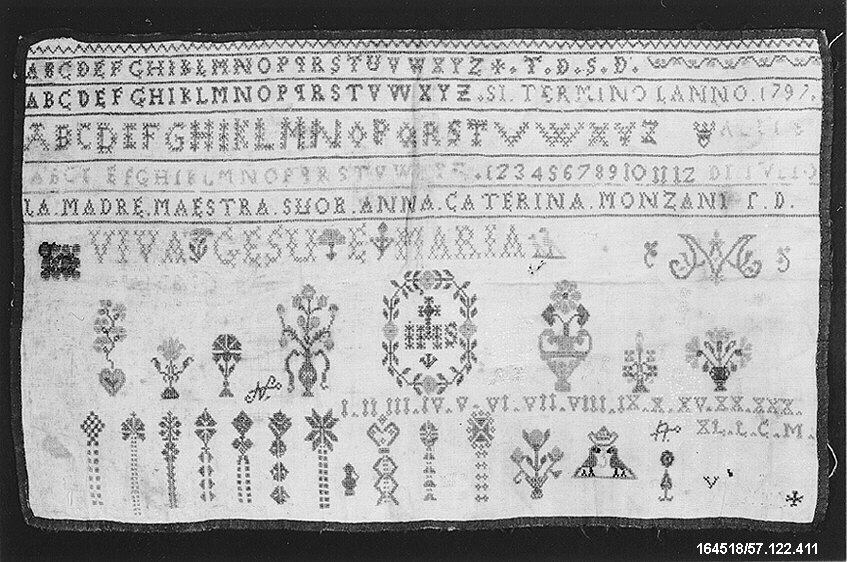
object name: sampler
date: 1797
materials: linen, silk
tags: birds